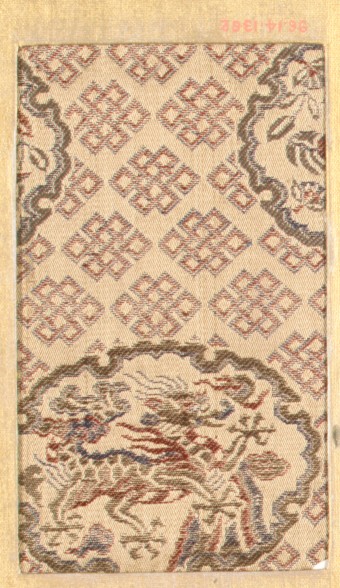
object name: piece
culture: japanese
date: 1701-1900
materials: silk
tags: dragons